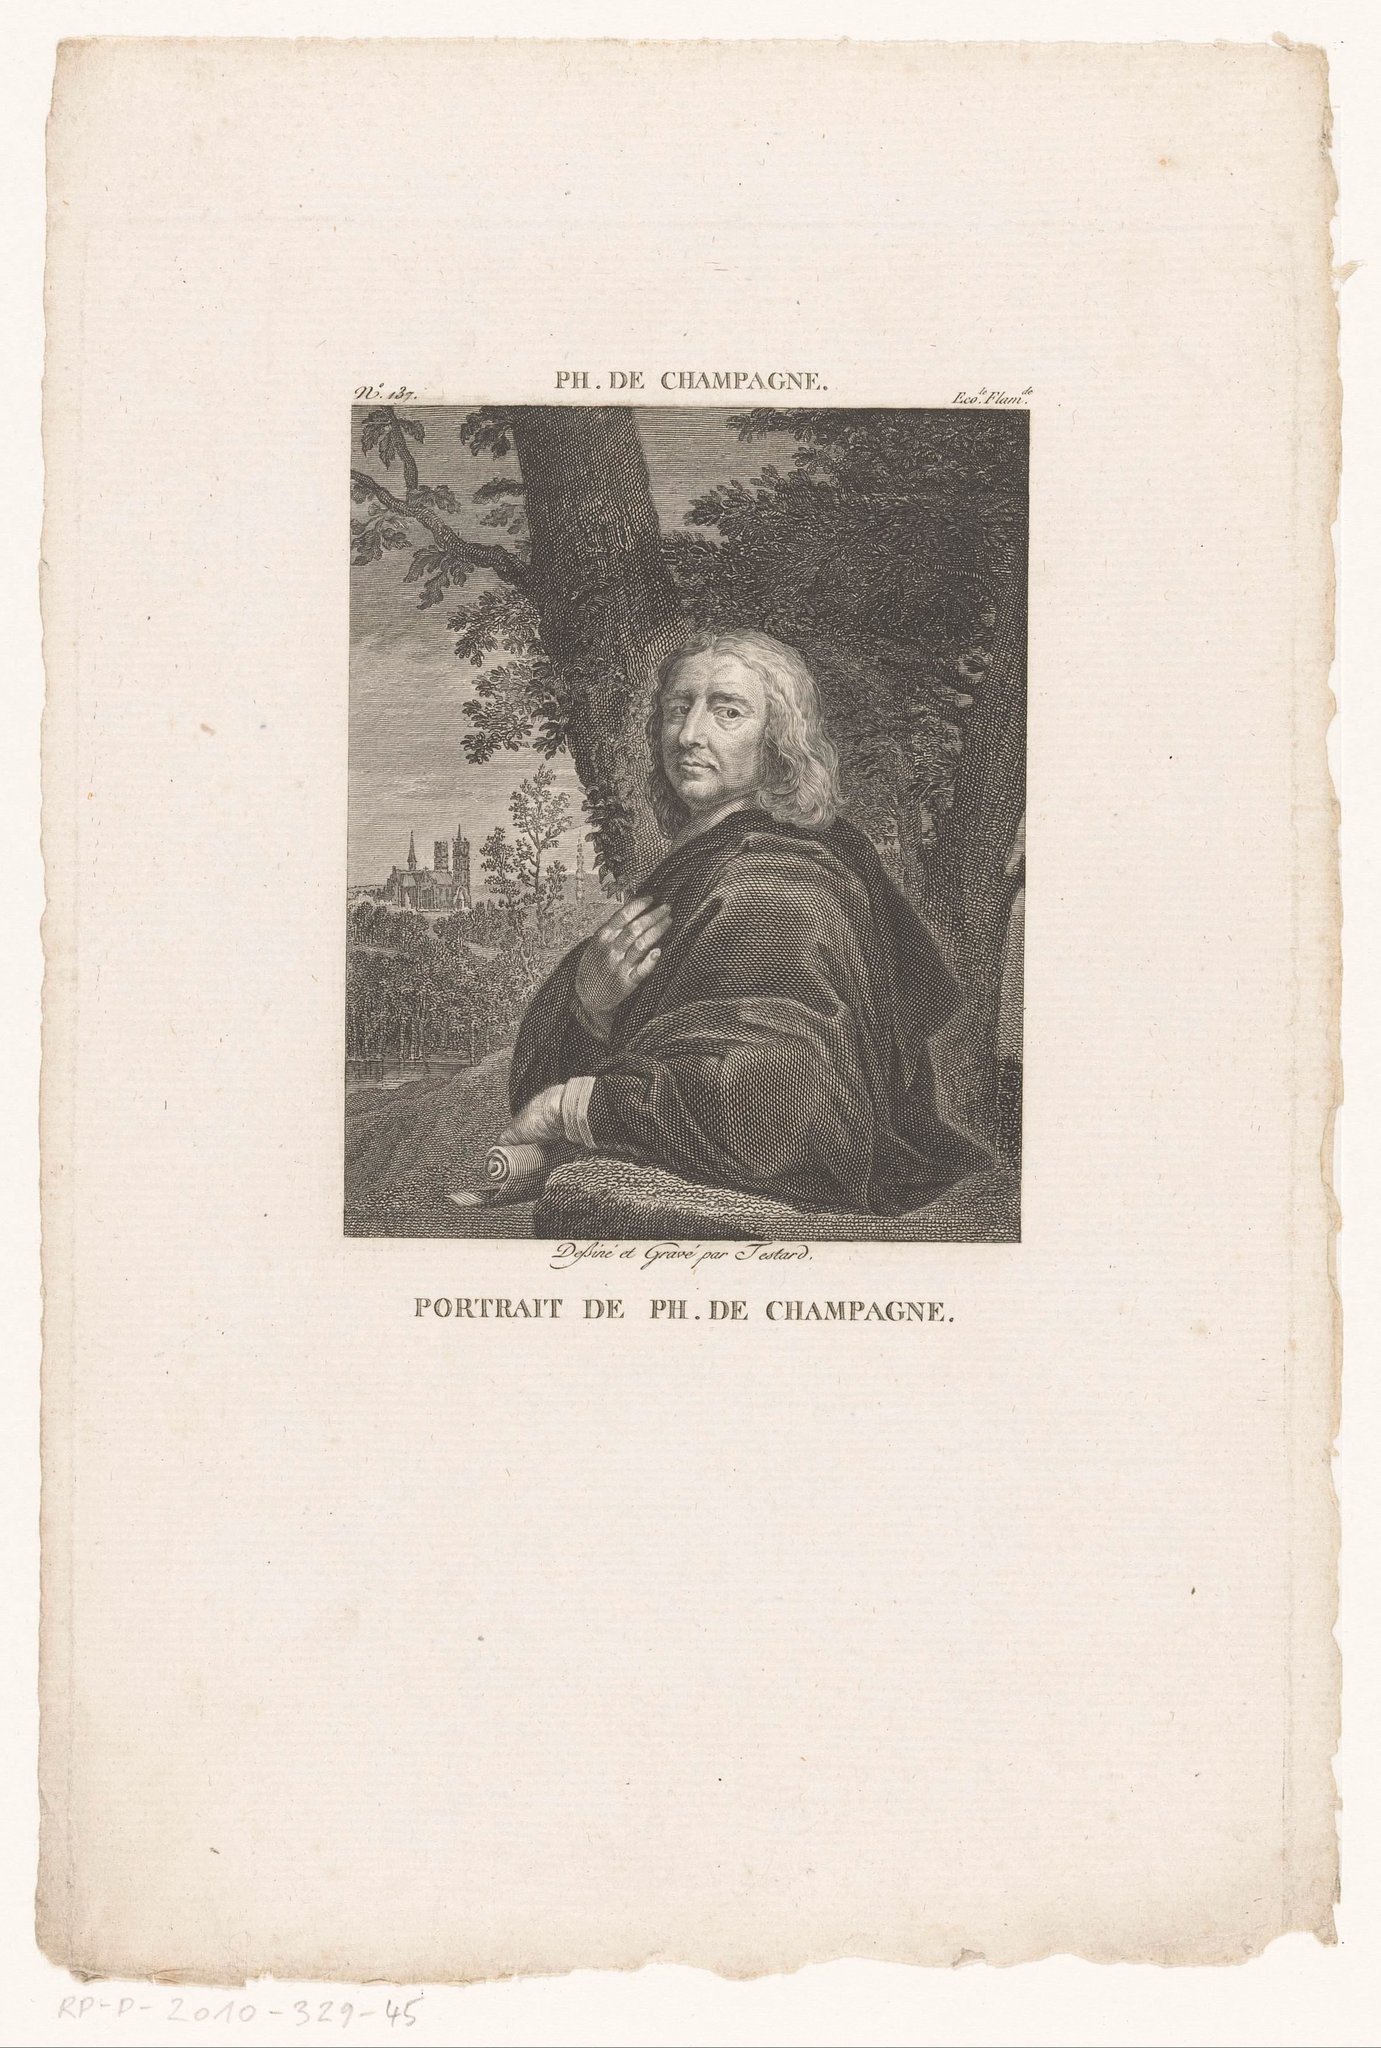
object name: print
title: Portrait de Ph. de Champagne.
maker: françois martin testard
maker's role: painter, print maker, publisher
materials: paper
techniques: engraving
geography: paris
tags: brussels, paris, painter, draughtsman, philippe de champaigne, historical persons, portrait, self-portrait of painter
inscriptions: collector's mark: Lugt 2228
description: Philip de Champagne (1602-16740). Portret ten halven lijve, naar links, papierrol in de hand, staand voor bomenlandschap. Links in de verte een kasteel.